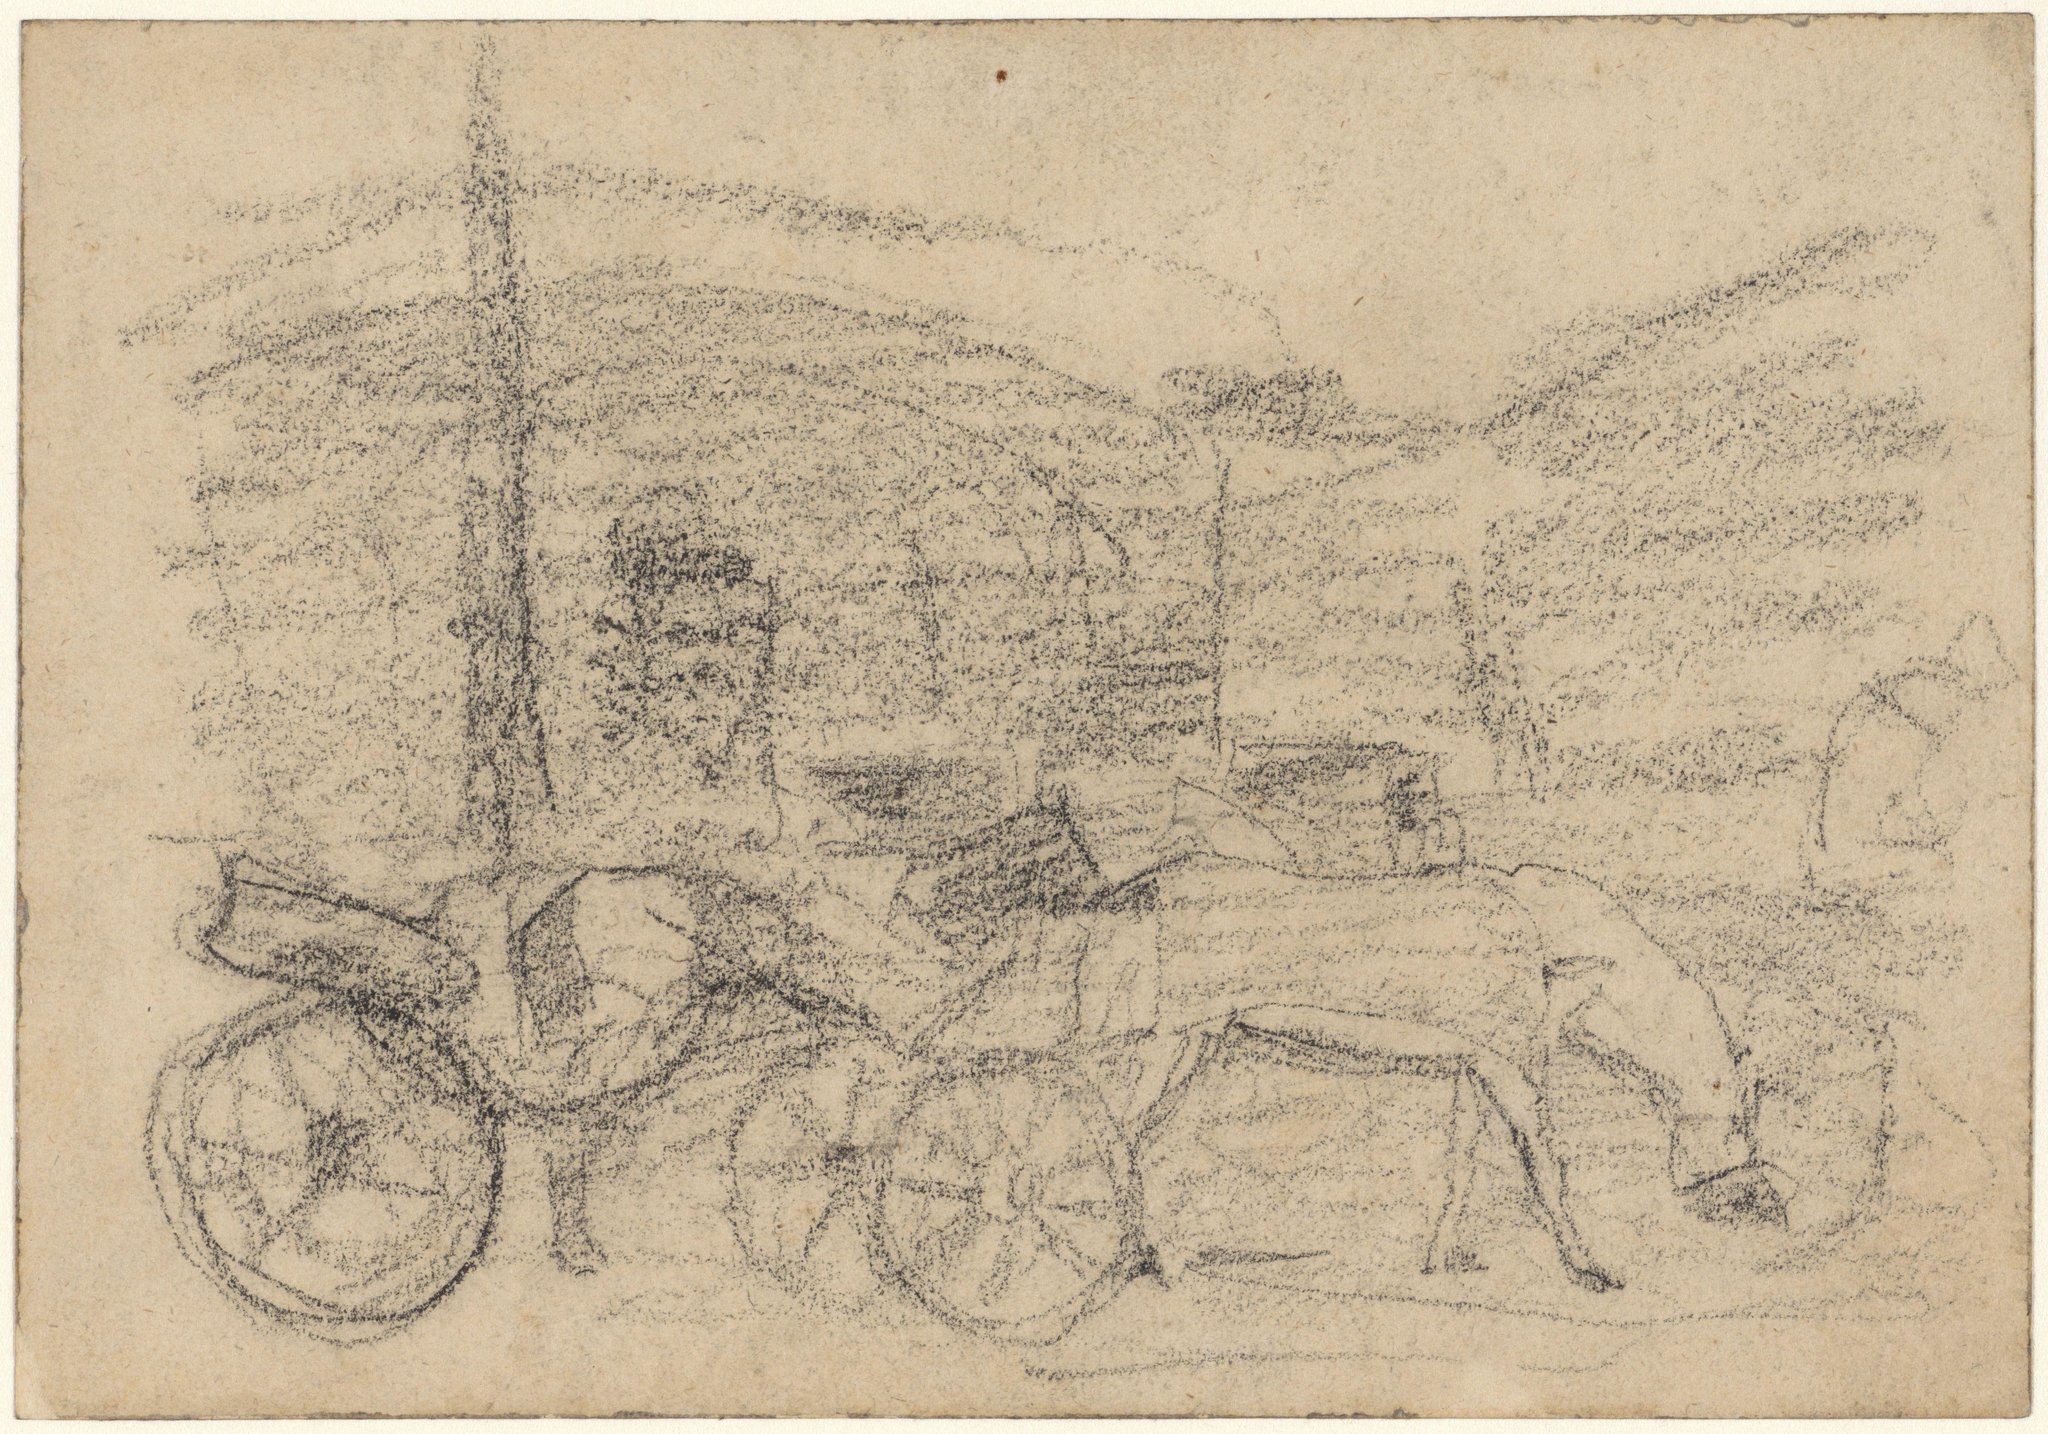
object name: drawing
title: Wachtend koetsje, Berlijn 1888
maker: theo nieuwenhuis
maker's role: designer, draughtsman, print maker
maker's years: 1866-1951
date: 1888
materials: chalk, paper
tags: four-wheeled, animal-drawn vehicle, e.g.: cab, carriage, coach, berlin